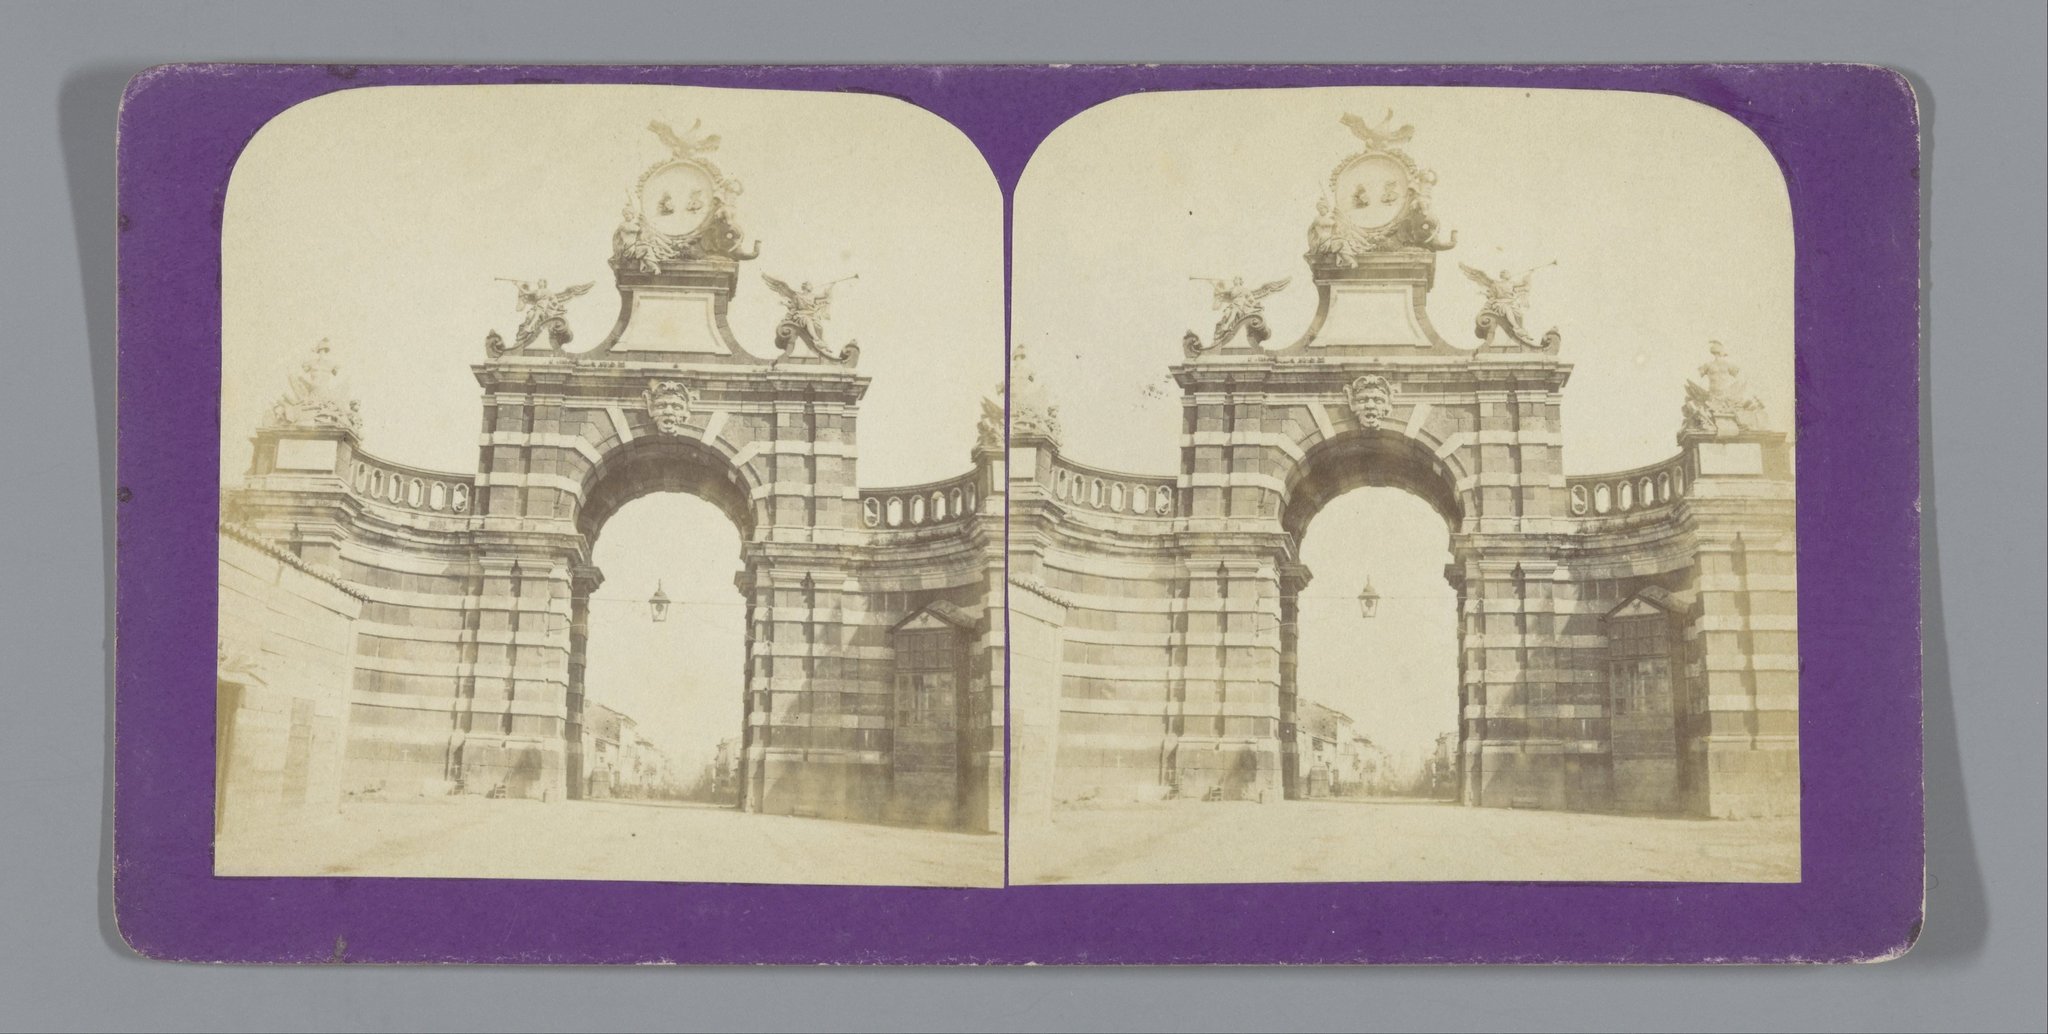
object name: stereograph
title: Porte Garibaldi, Catane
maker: jean andrieu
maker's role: fotograaf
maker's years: 1816-1872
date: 1862-1876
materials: cardboard, paper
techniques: albumen print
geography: catania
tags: triumphal arch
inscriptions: title: ‘1409 porte Garibaldi Catane’